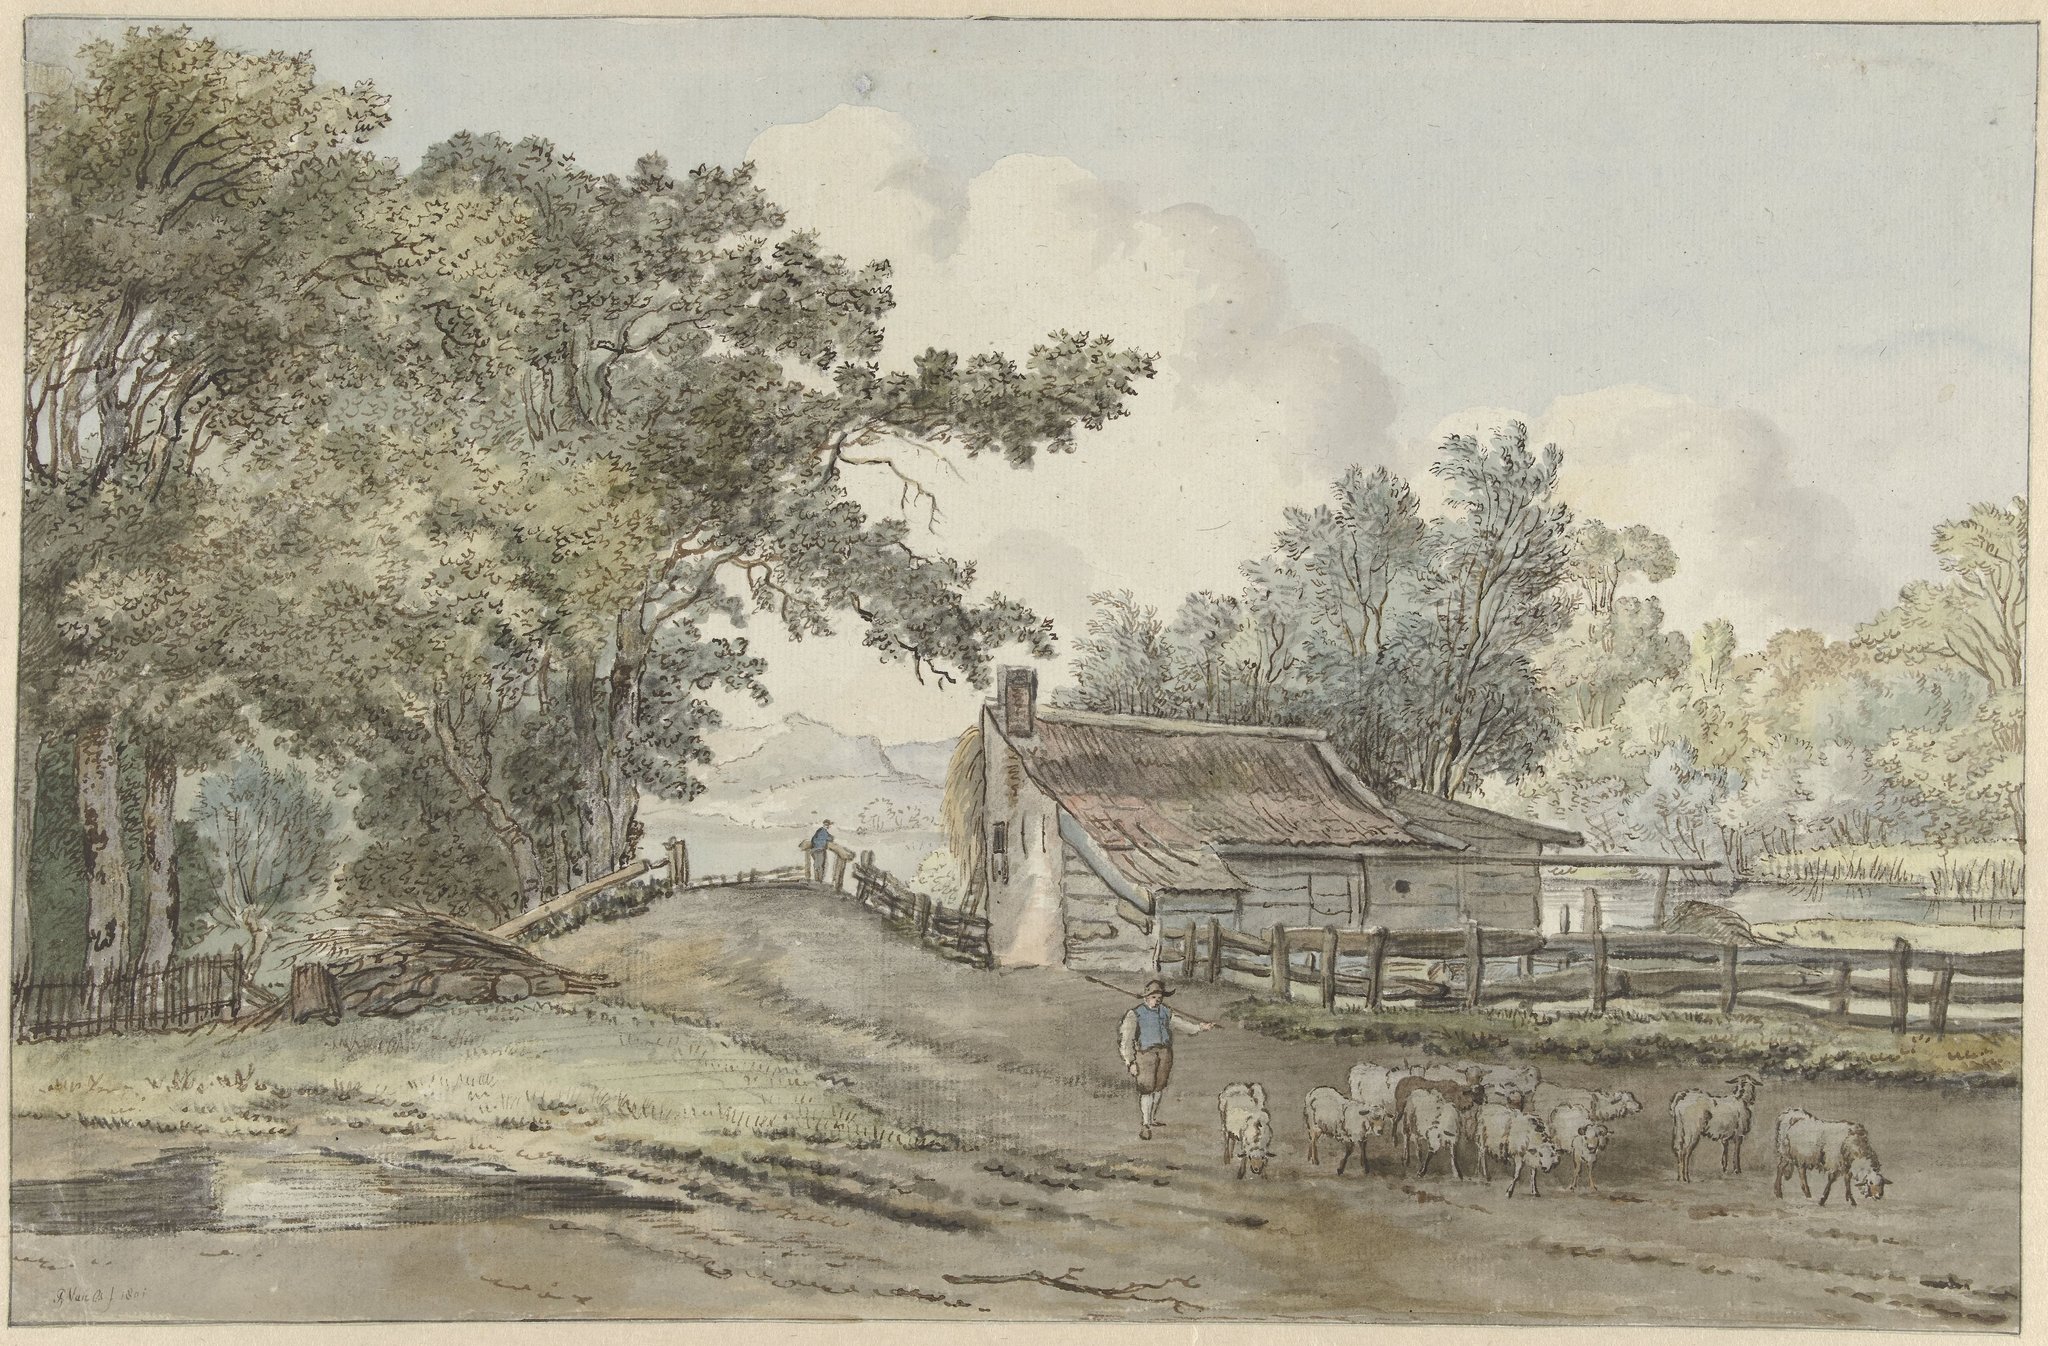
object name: drawing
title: Elswoutshoek te Overveen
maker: pieter gerardus van os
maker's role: draughtsman, painter, print maker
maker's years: 1776-1839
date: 1801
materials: chalk, ink, paper, watercolor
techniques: brush, pen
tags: city-view, and landscape with man-made constructions, rural housing, e.g. country-house, villa, cottage